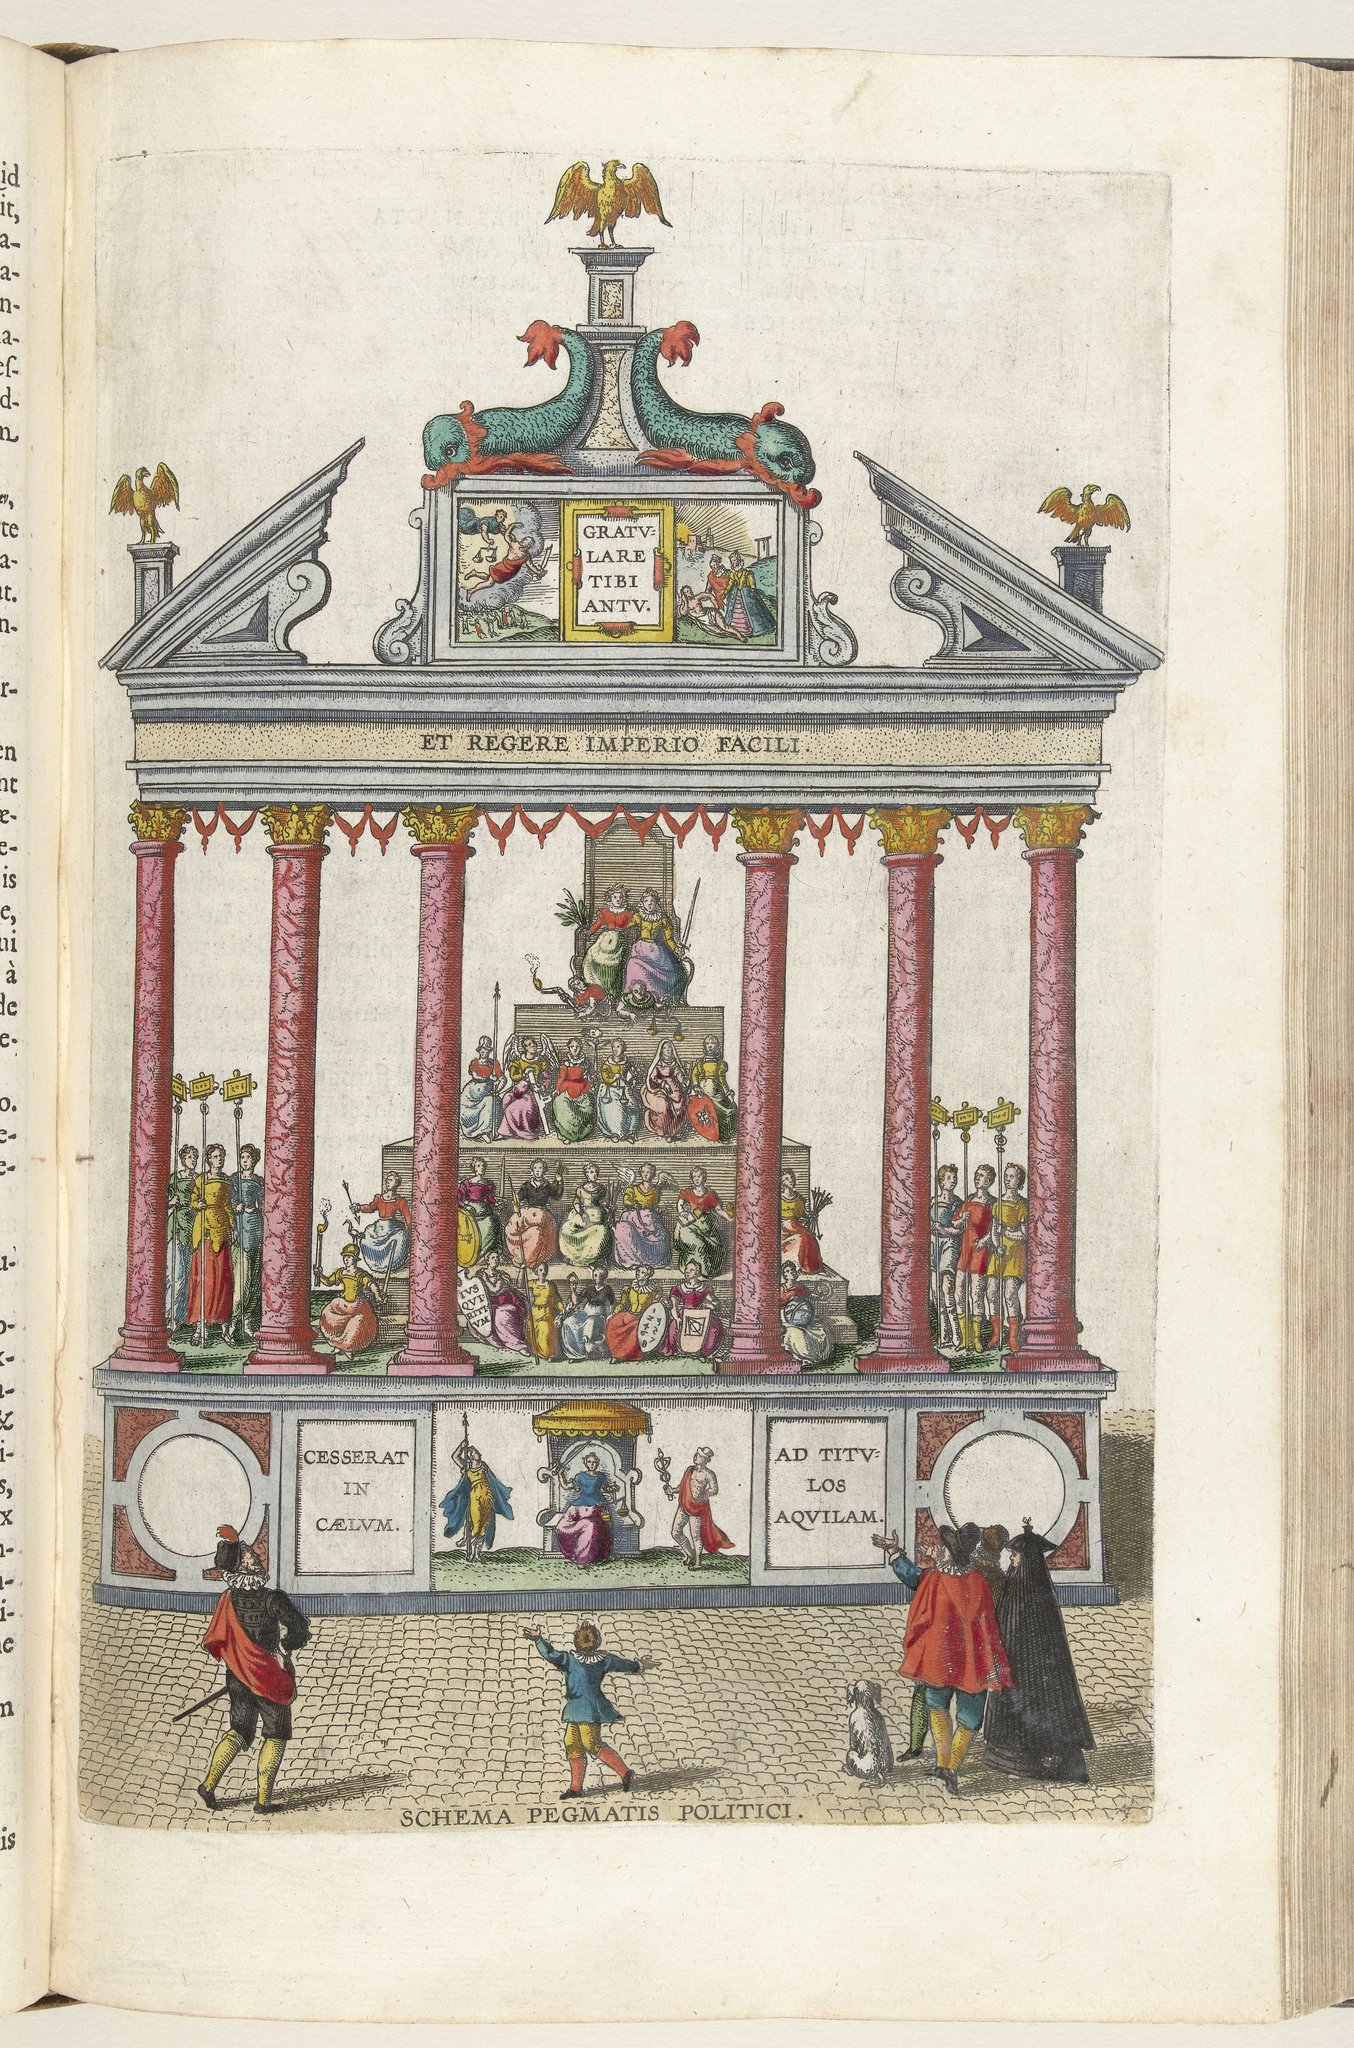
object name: print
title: Toneel met Vrede en Gerechtigheid, 1599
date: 1599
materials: paper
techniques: etching, hand coloring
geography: antwerp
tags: infante van spanje isabella clara eugenia, brussels, albrecht aartshertog van oostenrijk, 'tableau vivant', triumphal entry and public reception, pageant, 'entrée solennelle', 'joyeuse entrée', antwerp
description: Politieke toneel met Vrede en Gerechtigheid, december 1599. Toneel met een stellage met personificaties van Vrede en Gerechtigheid en andere deugden. Tijdens de intocht te Antwerpen opgesteld voor het stadhuis op de Grote Markt. Onderdeel van: Historica narratio profectionis et inaugurationis serenissimorum Belgii principum Alberti et Isabellae Austriae archiducum, de beschrijving van de intochten van het paar te Brussel, Antwerpen, Gent en Valenciennes, 1599.